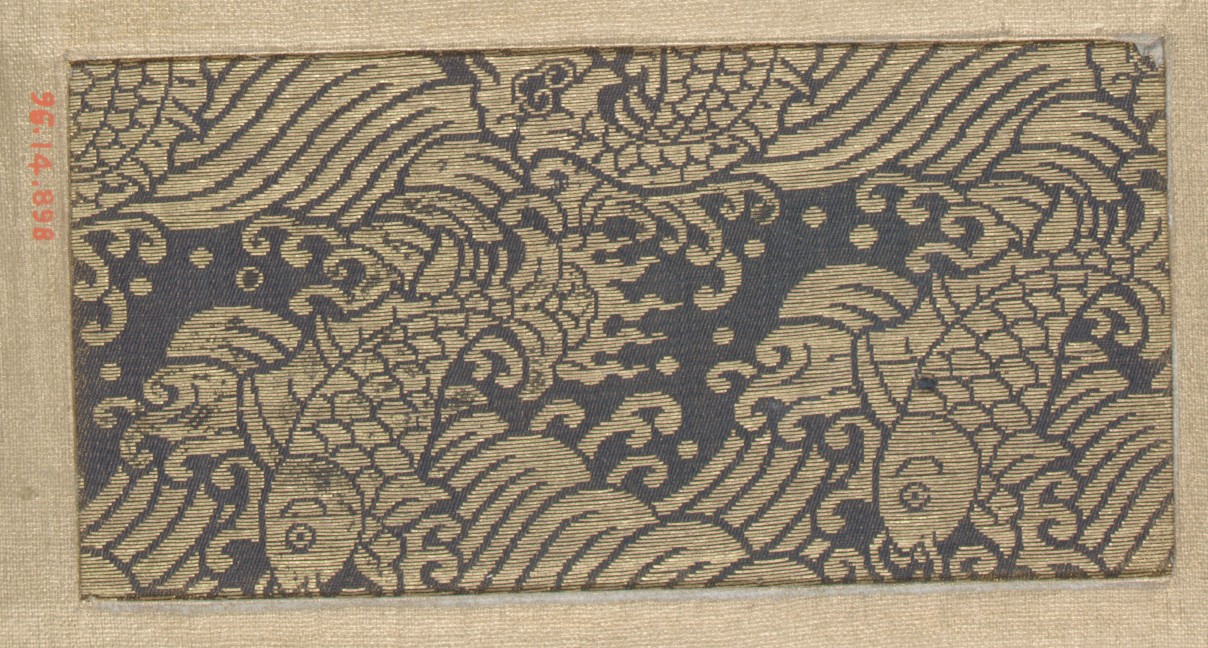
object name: piece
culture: japanese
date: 1701-1900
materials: silk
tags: fish,waves